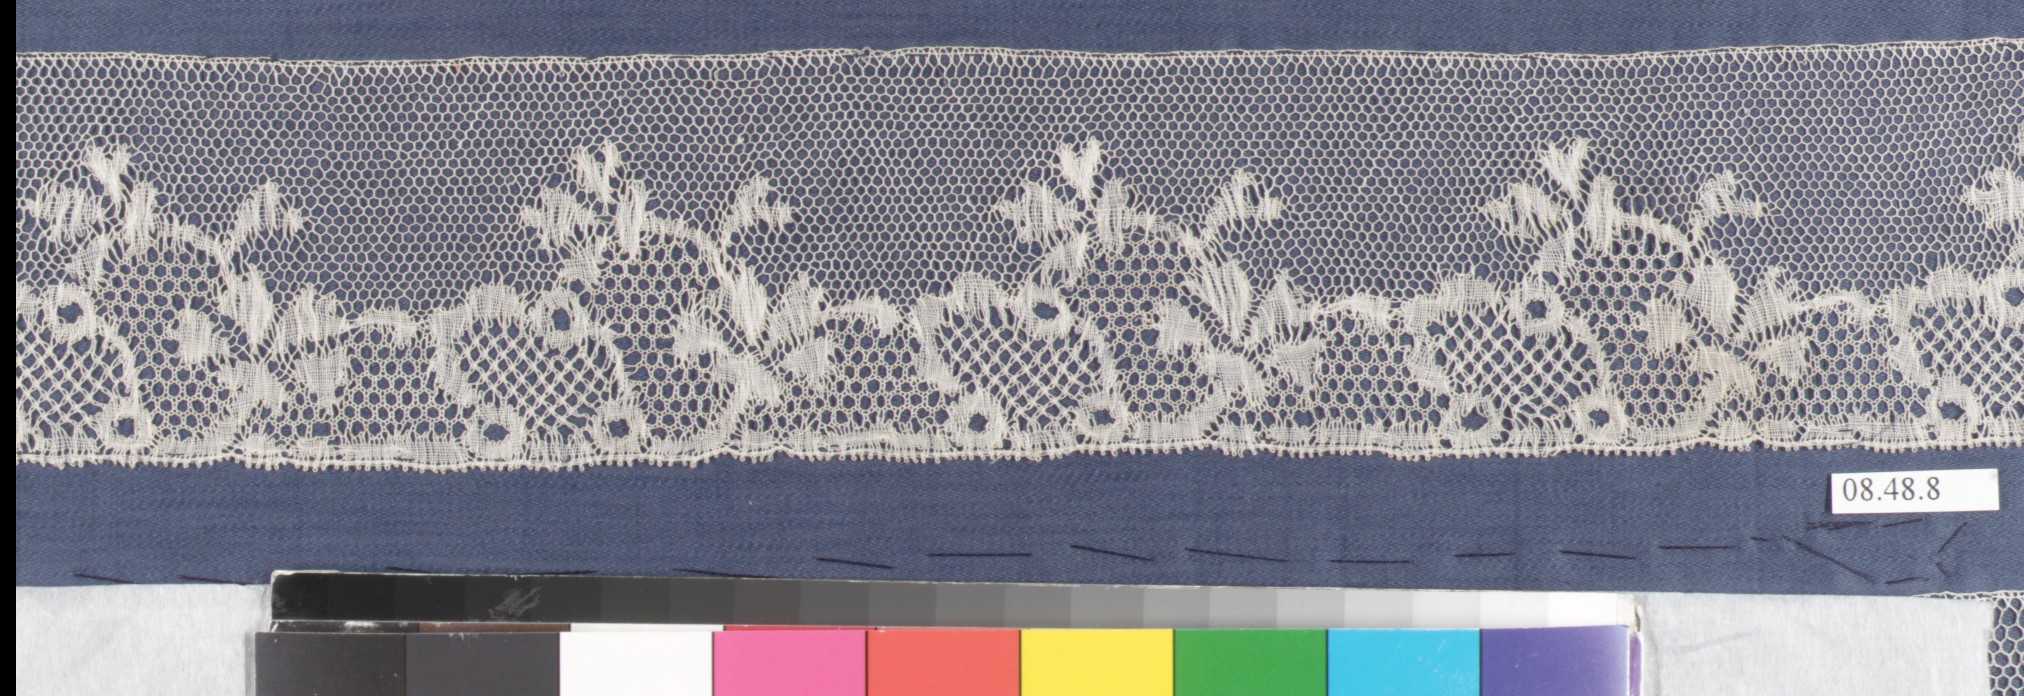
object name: edging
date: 1801-1900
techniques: lace